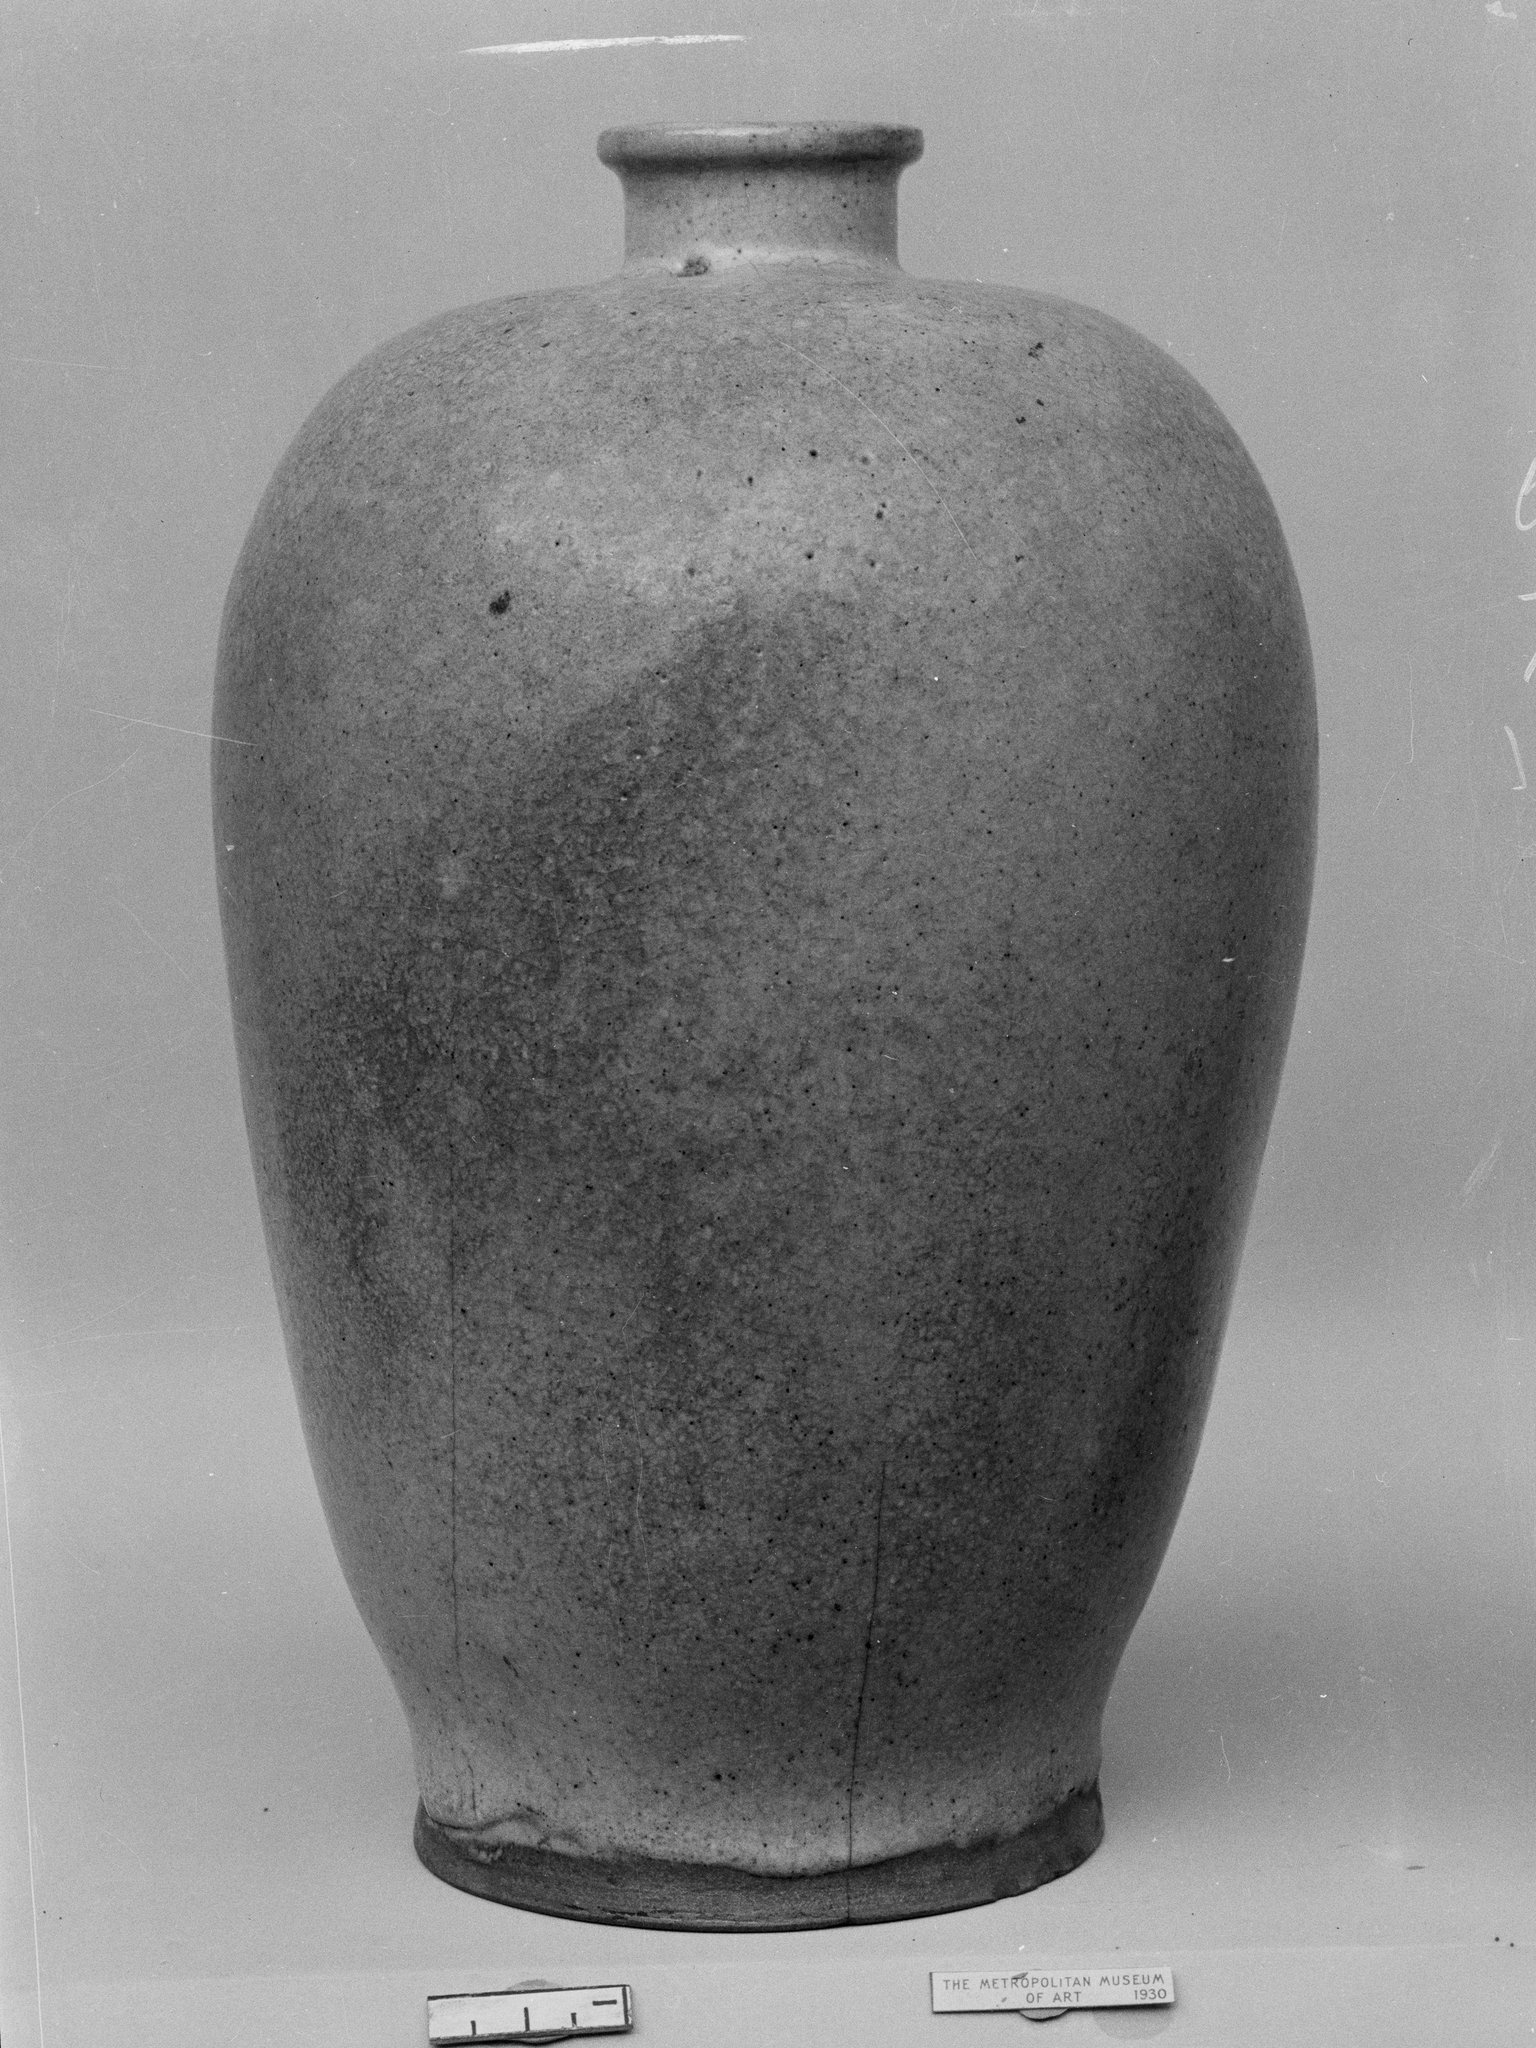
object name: vase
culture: chinese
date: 1271-1368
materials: glaze, stoneware